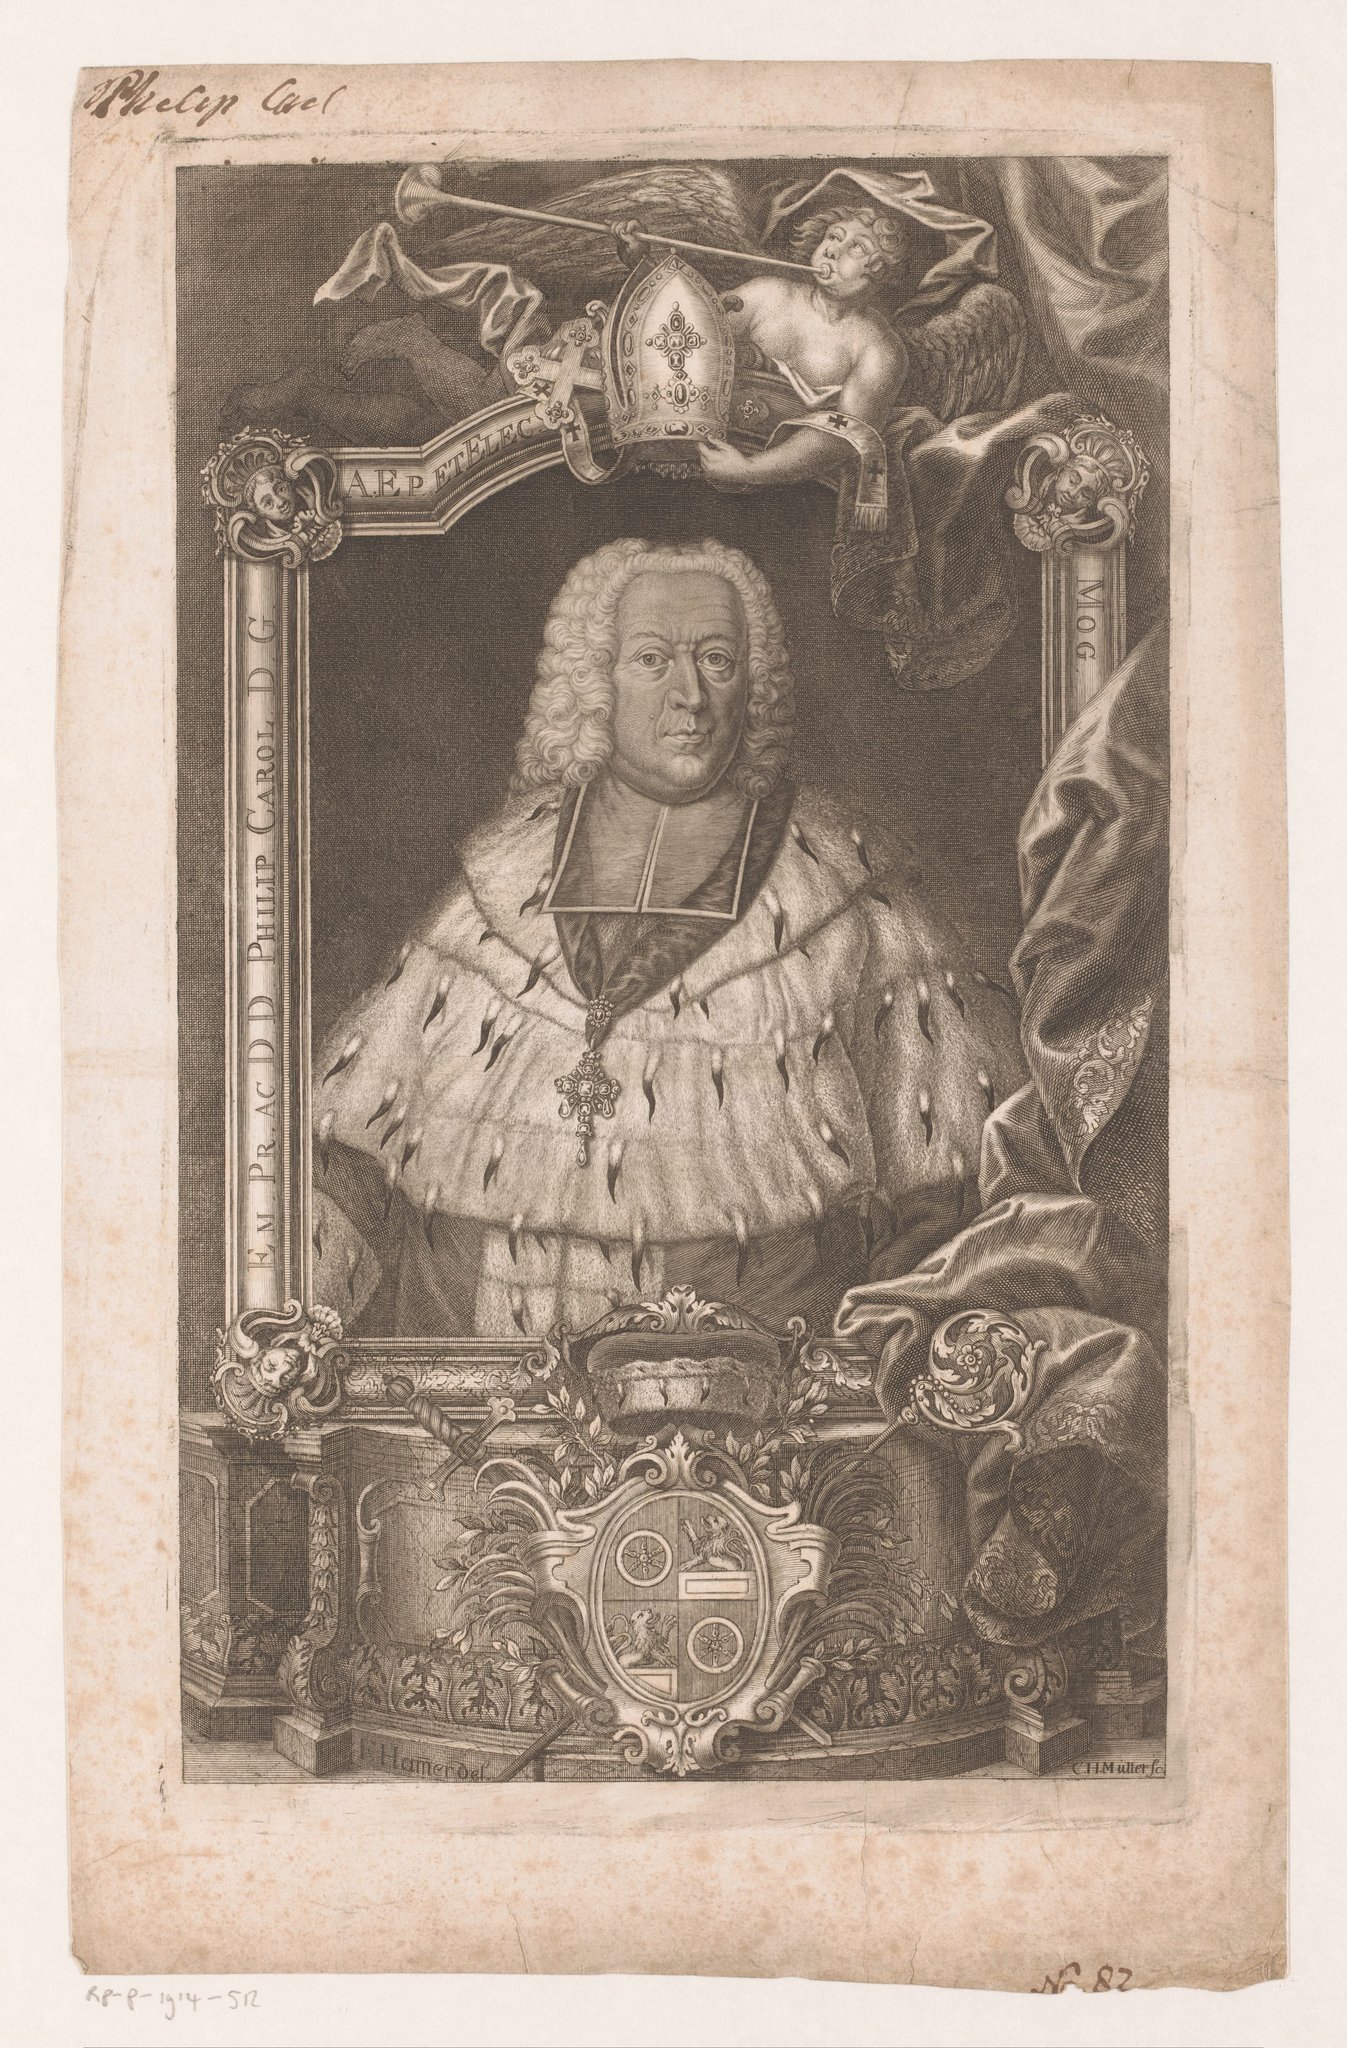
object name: print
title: Portret van Philipp Karl von Eltz-Kempenich, aartsbisschop van Mainz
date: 1732-1799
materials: paper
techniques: engraving, etching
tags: theologian, historical persons, crucifix ~ personal devotion, armorial bearing, heraldry, insignia and symbols of sovereignty (crown, diadem, sceptre, orb, seal, standard, cloak, pectoral)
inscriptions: collector's mark: Lugt 2228